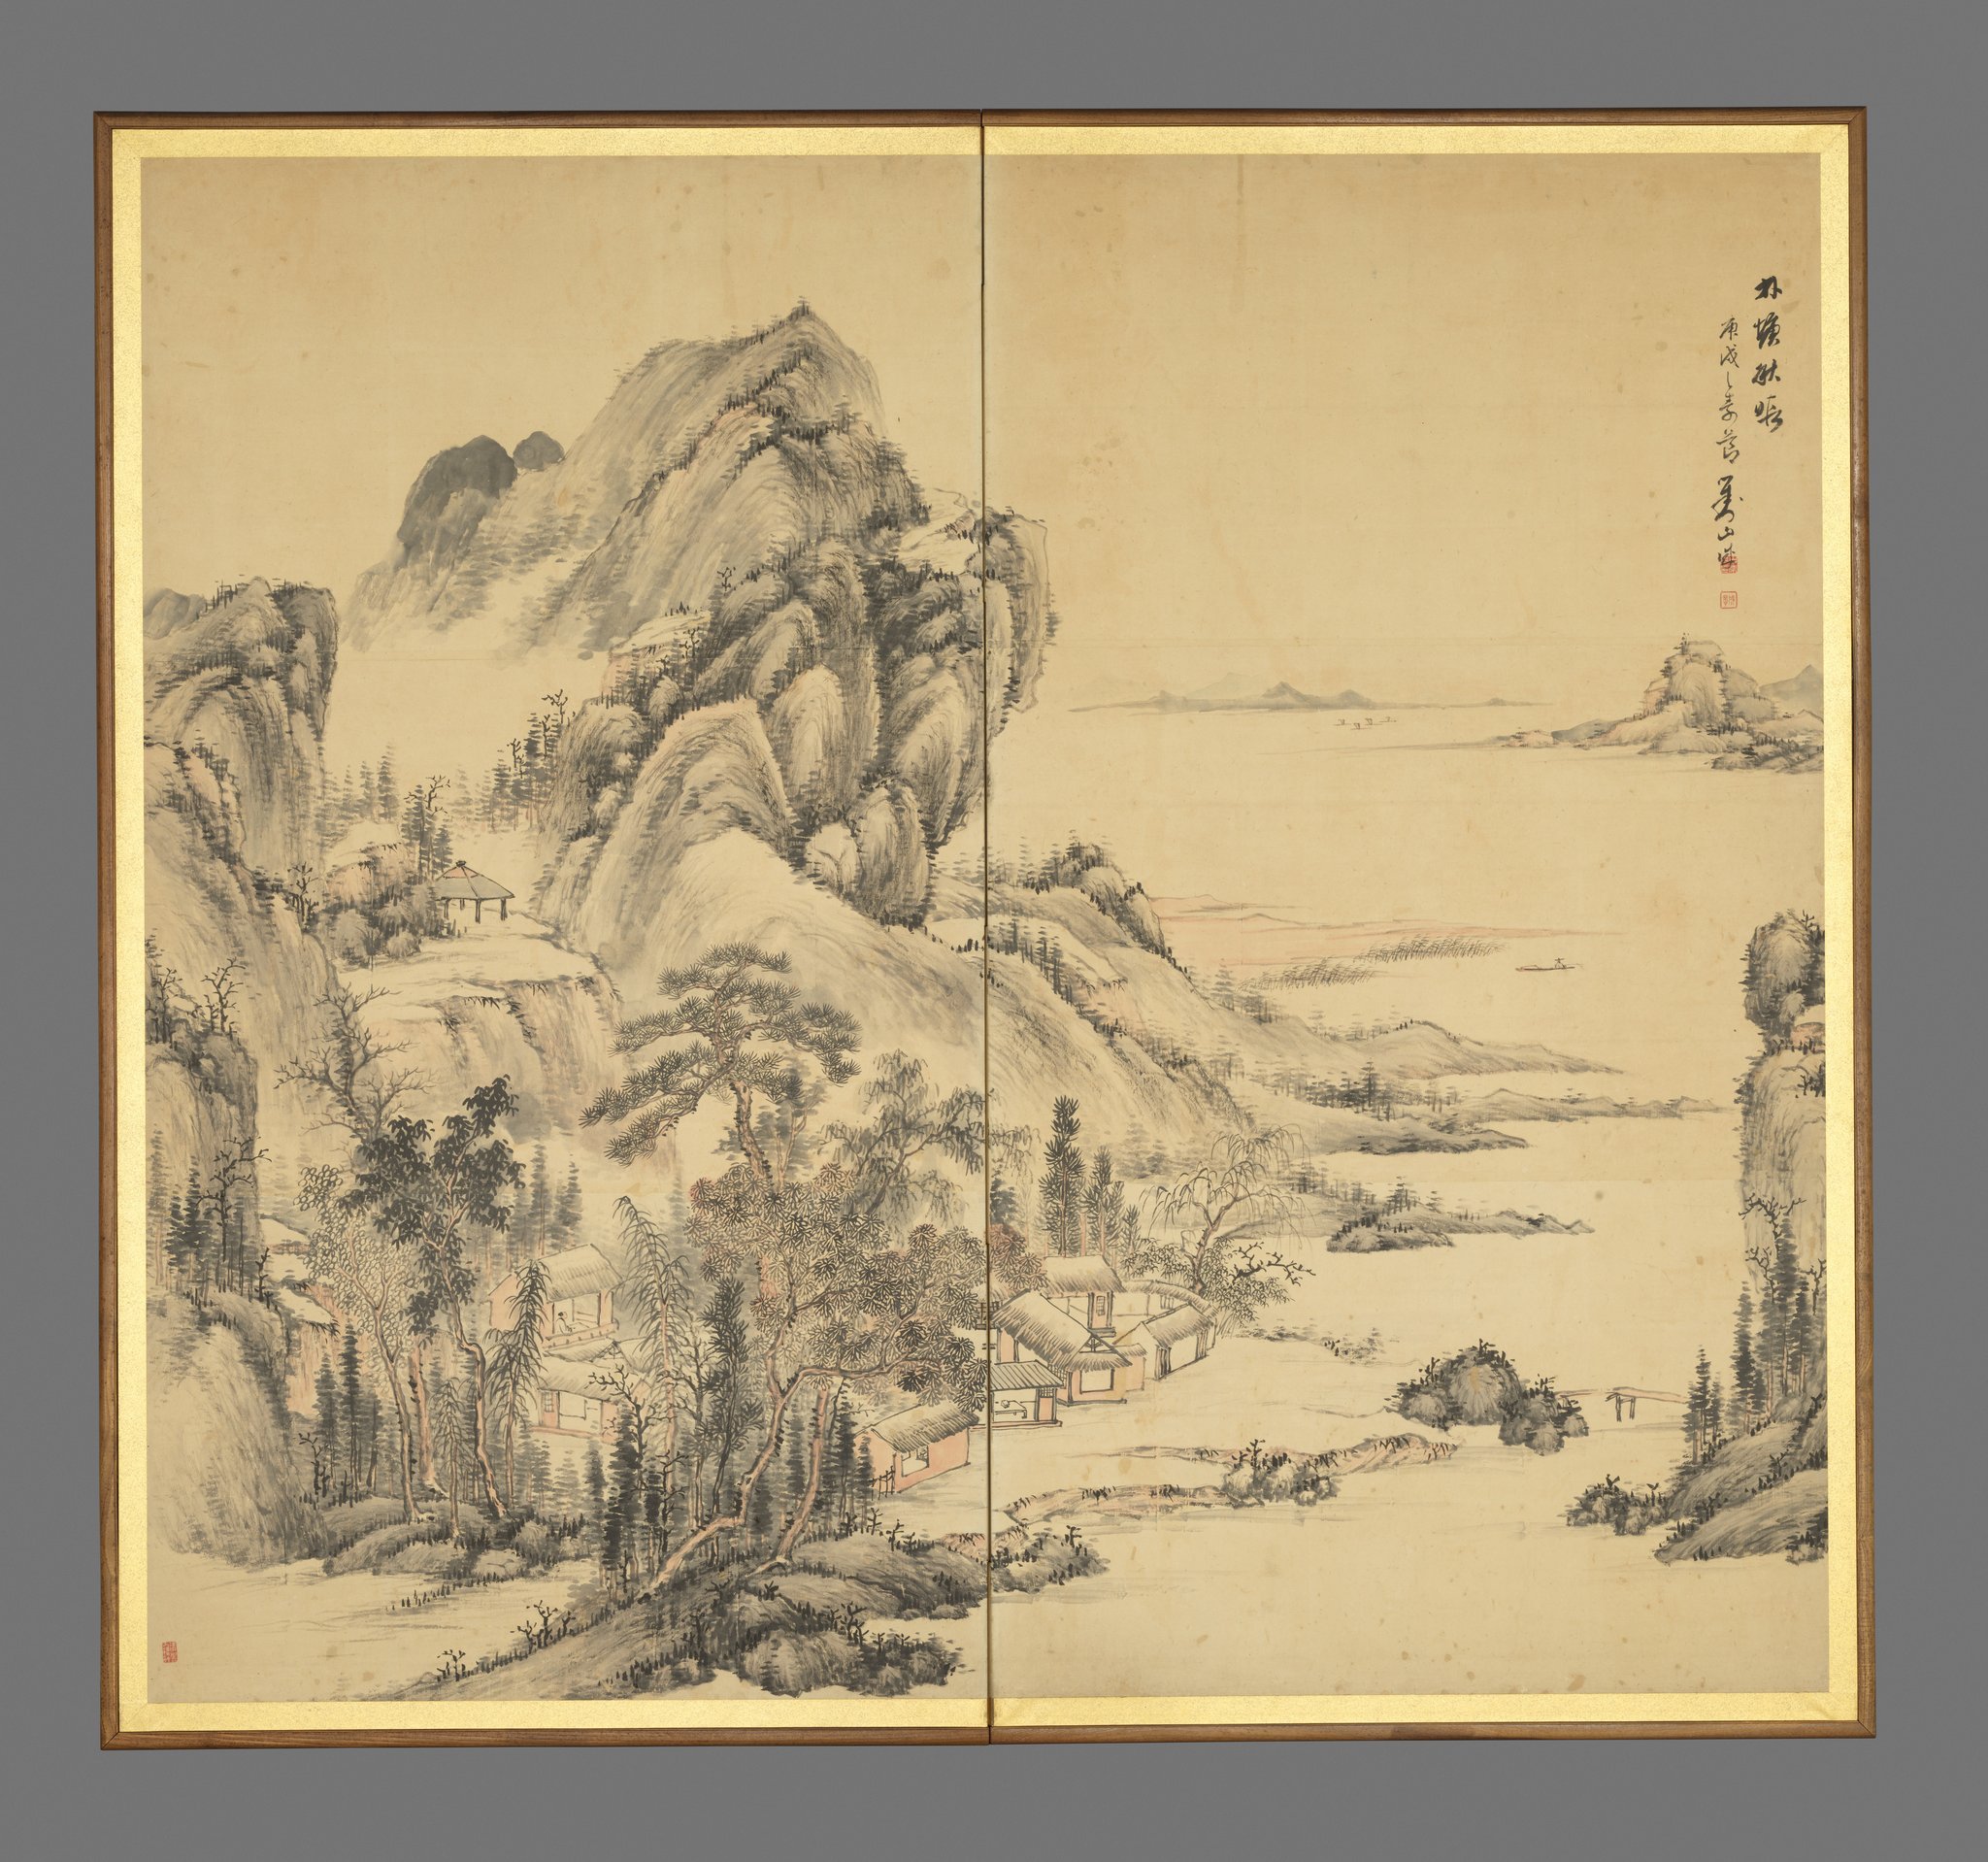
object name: screen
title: “At leisure in a lakeside grove in autumn”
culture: japanese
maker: hine taizan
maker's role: artist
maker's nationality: japanese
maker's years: 1813-1869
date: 1850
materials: panel